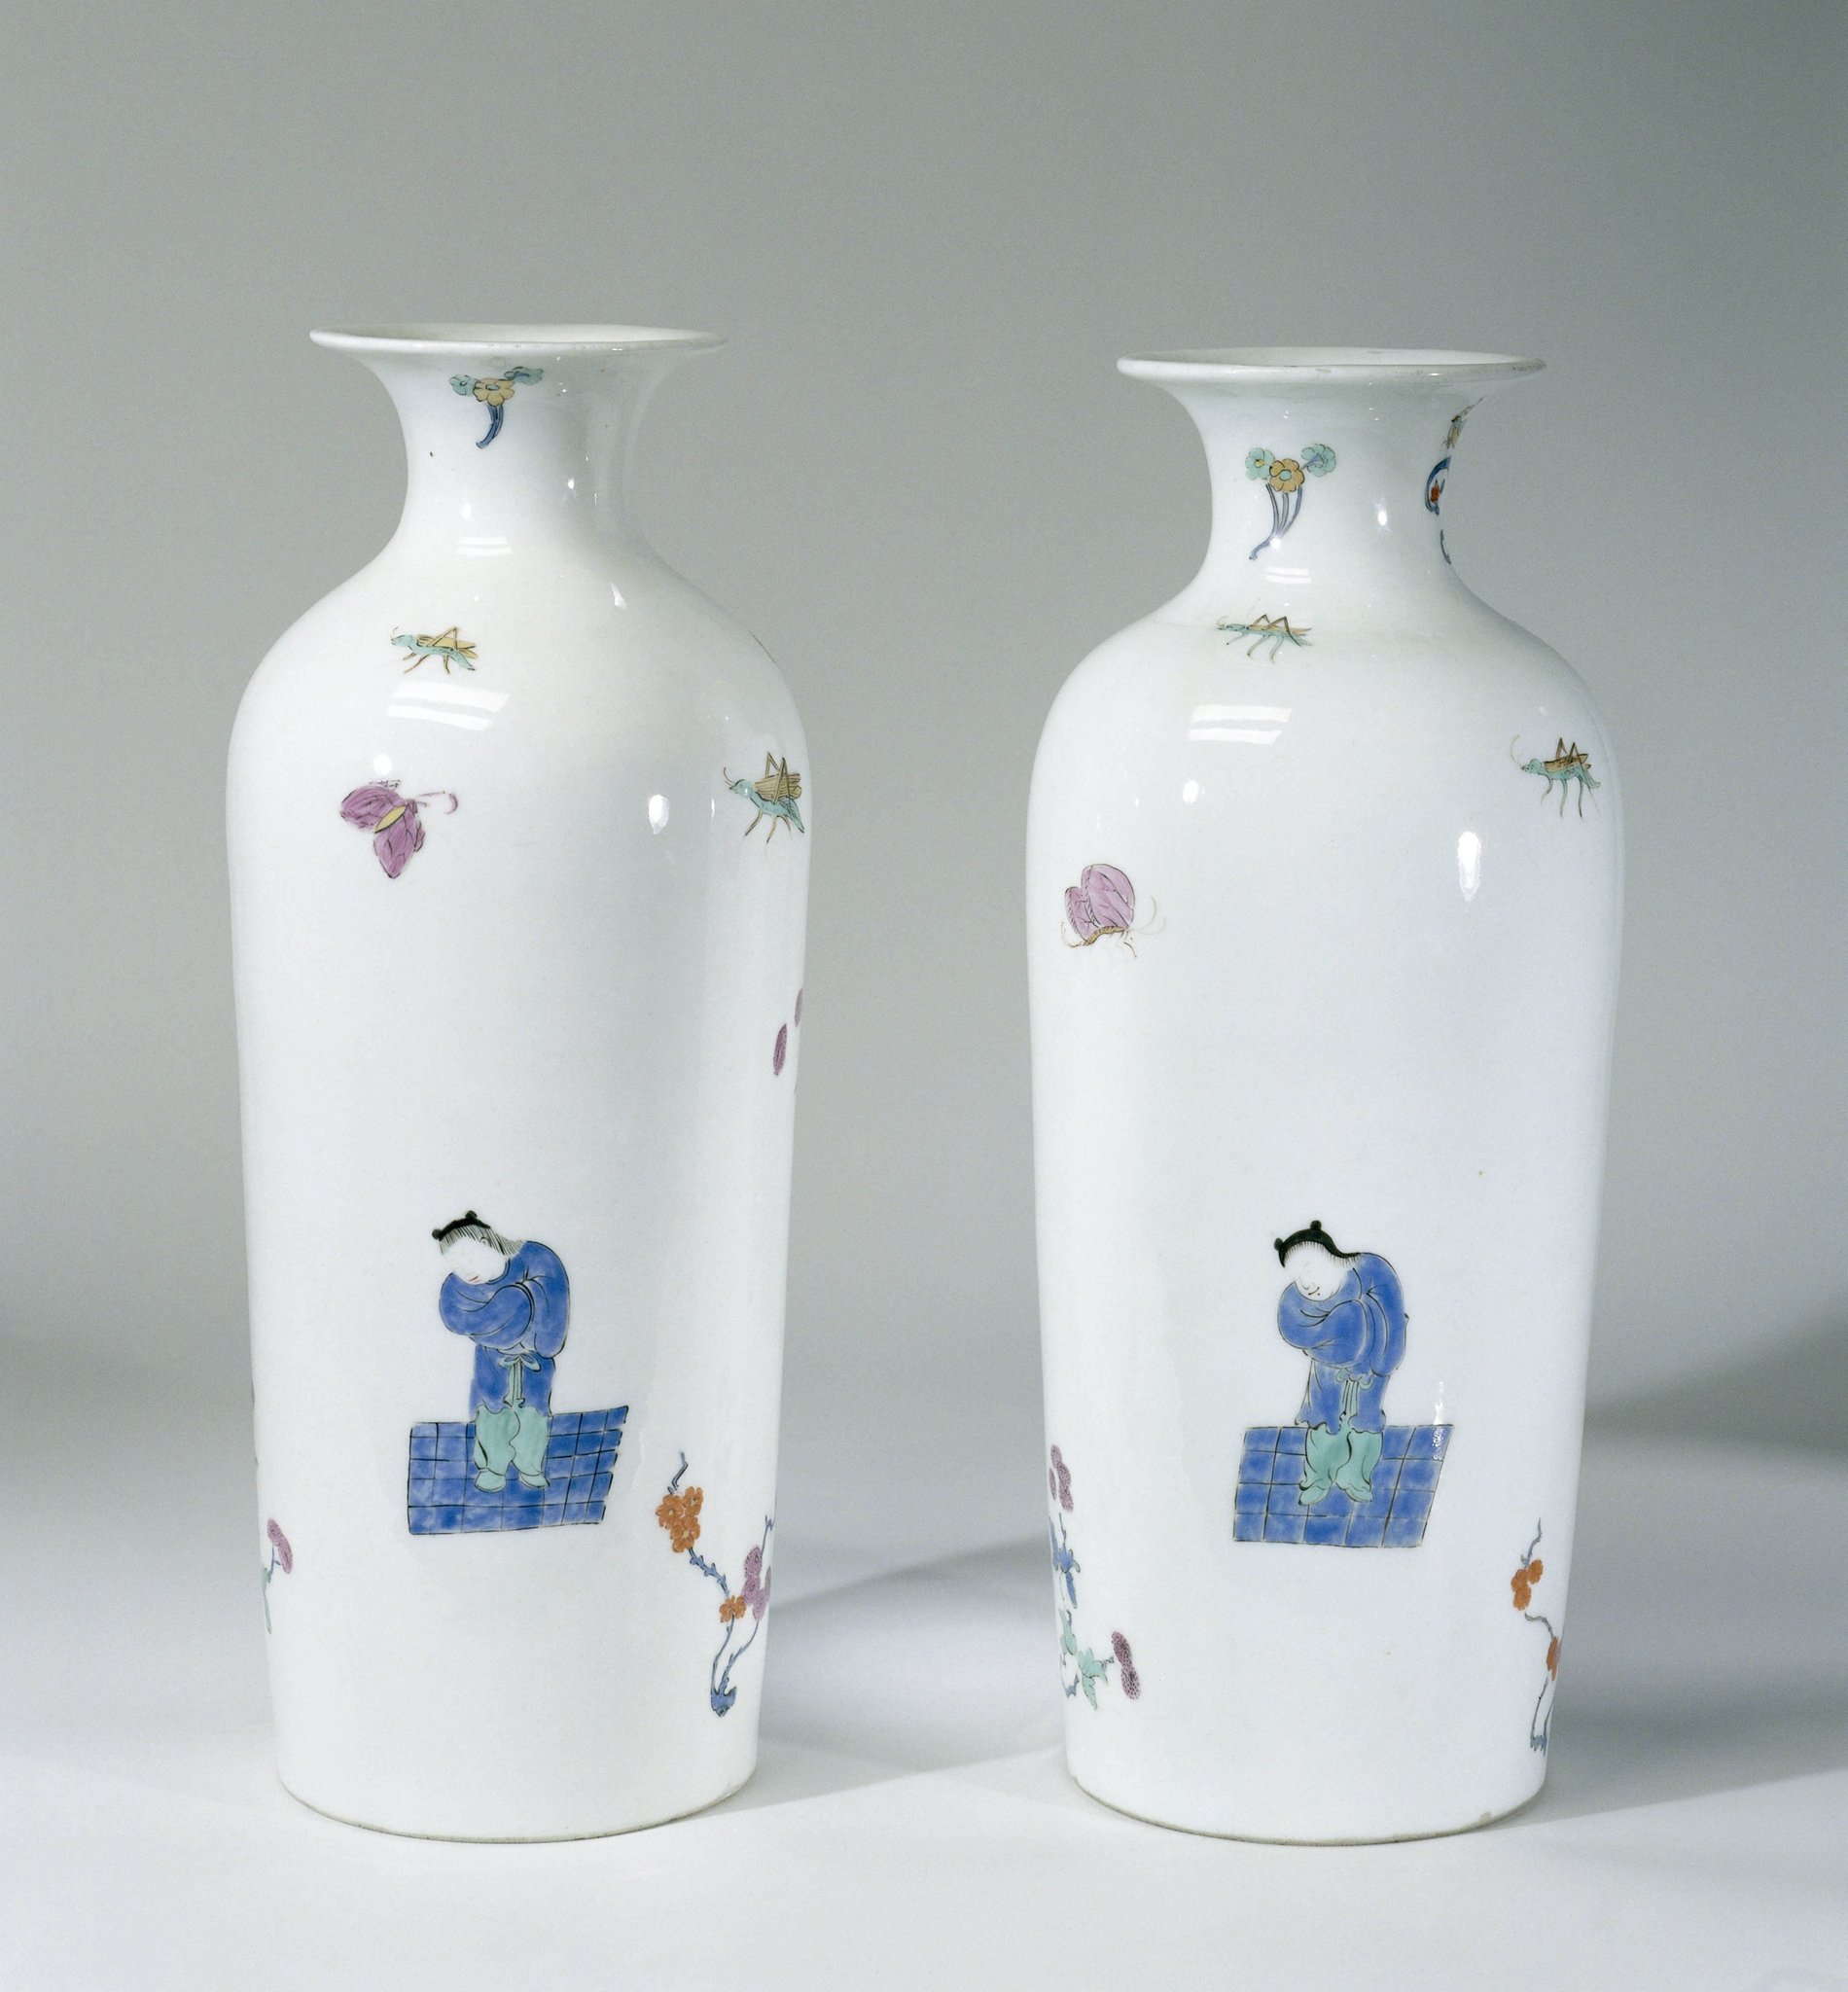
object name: vase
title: Vaas, veelkleurig beschilderd met een Kakiemon-decor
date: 1725-1730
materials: porcelain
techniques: painted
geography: meissen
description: Two cylindrical vases. Porcelain. Meissen, c. 1725.